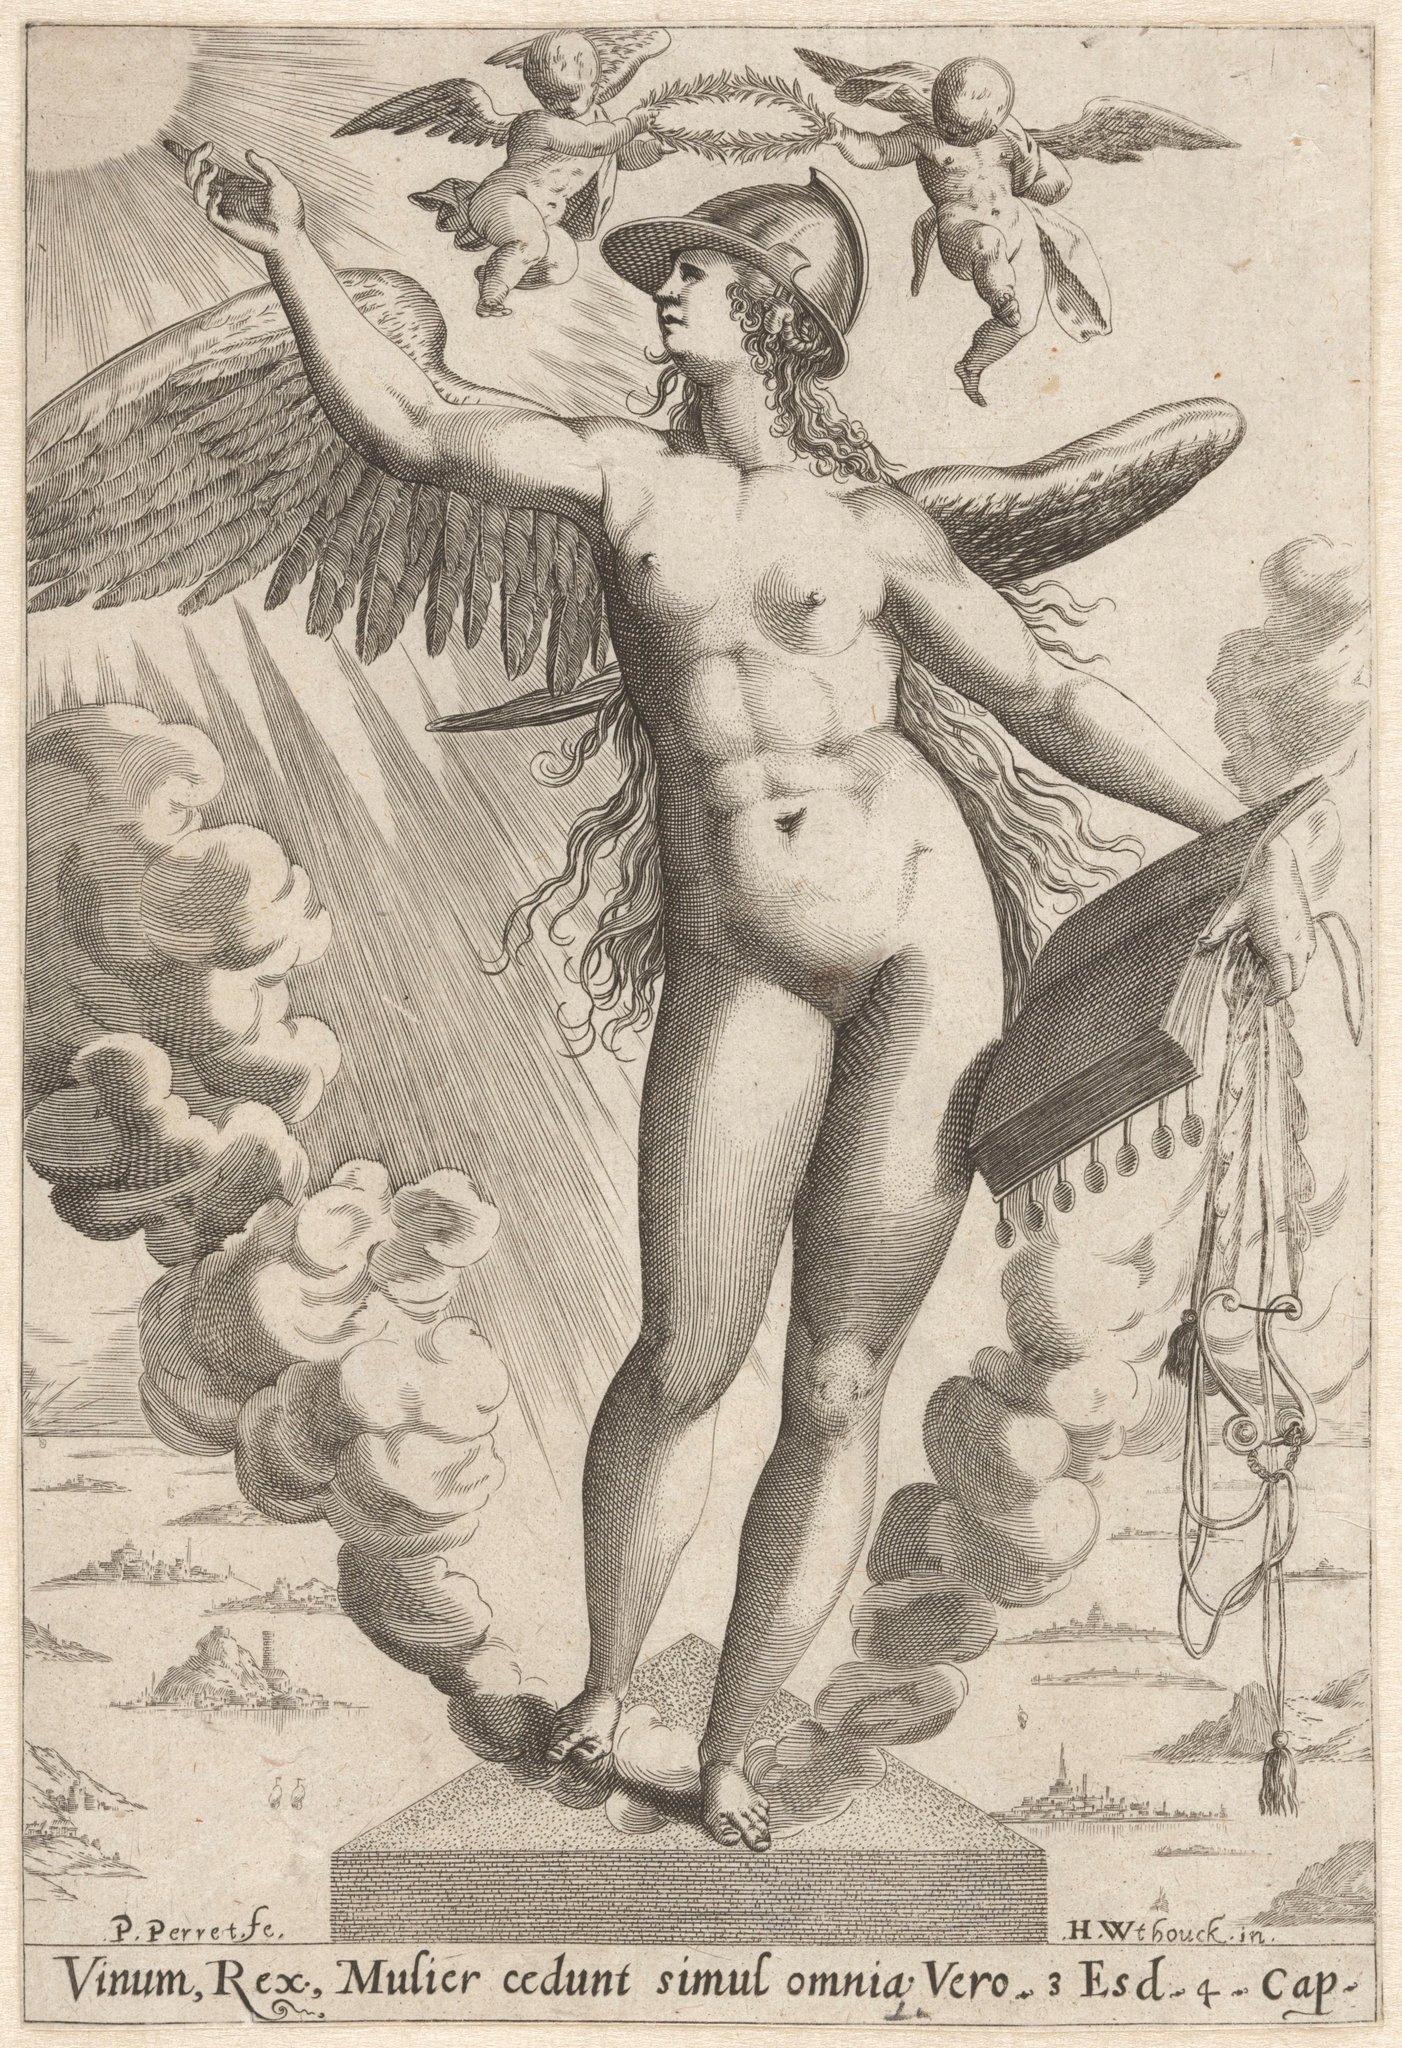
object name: print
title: Allegorie op de macht der waarheid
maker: pieter perret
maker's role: print maker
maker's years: 1555-1639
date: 1565-1639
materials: paper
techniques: engraving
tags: zerubbabel says (writes) that truth is the strongest of all things ~ contest of the three guardsmen, truth; 'verità' (ripa), reins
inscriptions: collector's mark: Lugt 2760, collector's mark: Lugt 2228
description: Allegorie op de macht der waarheid. Een naakte gevleugelde vrouwelijke personificatie van de Waarheid, staande op een driehoek wijst met haar rechterhand naar de zon. In haar linkerhand houdt ze een geopend boek met zeven zegels en hoofdstel met teugels. Ze wordt gekroond met een lauwerkrans door twee engeltjes. Het onderschrift verwijst naar de wedstrijd onder de lijfwachten van de Perzische koning Darius over wie de machtigste is (3 Esdras 4: 13-33). Onderdeel van een serie van vier allegorieën.